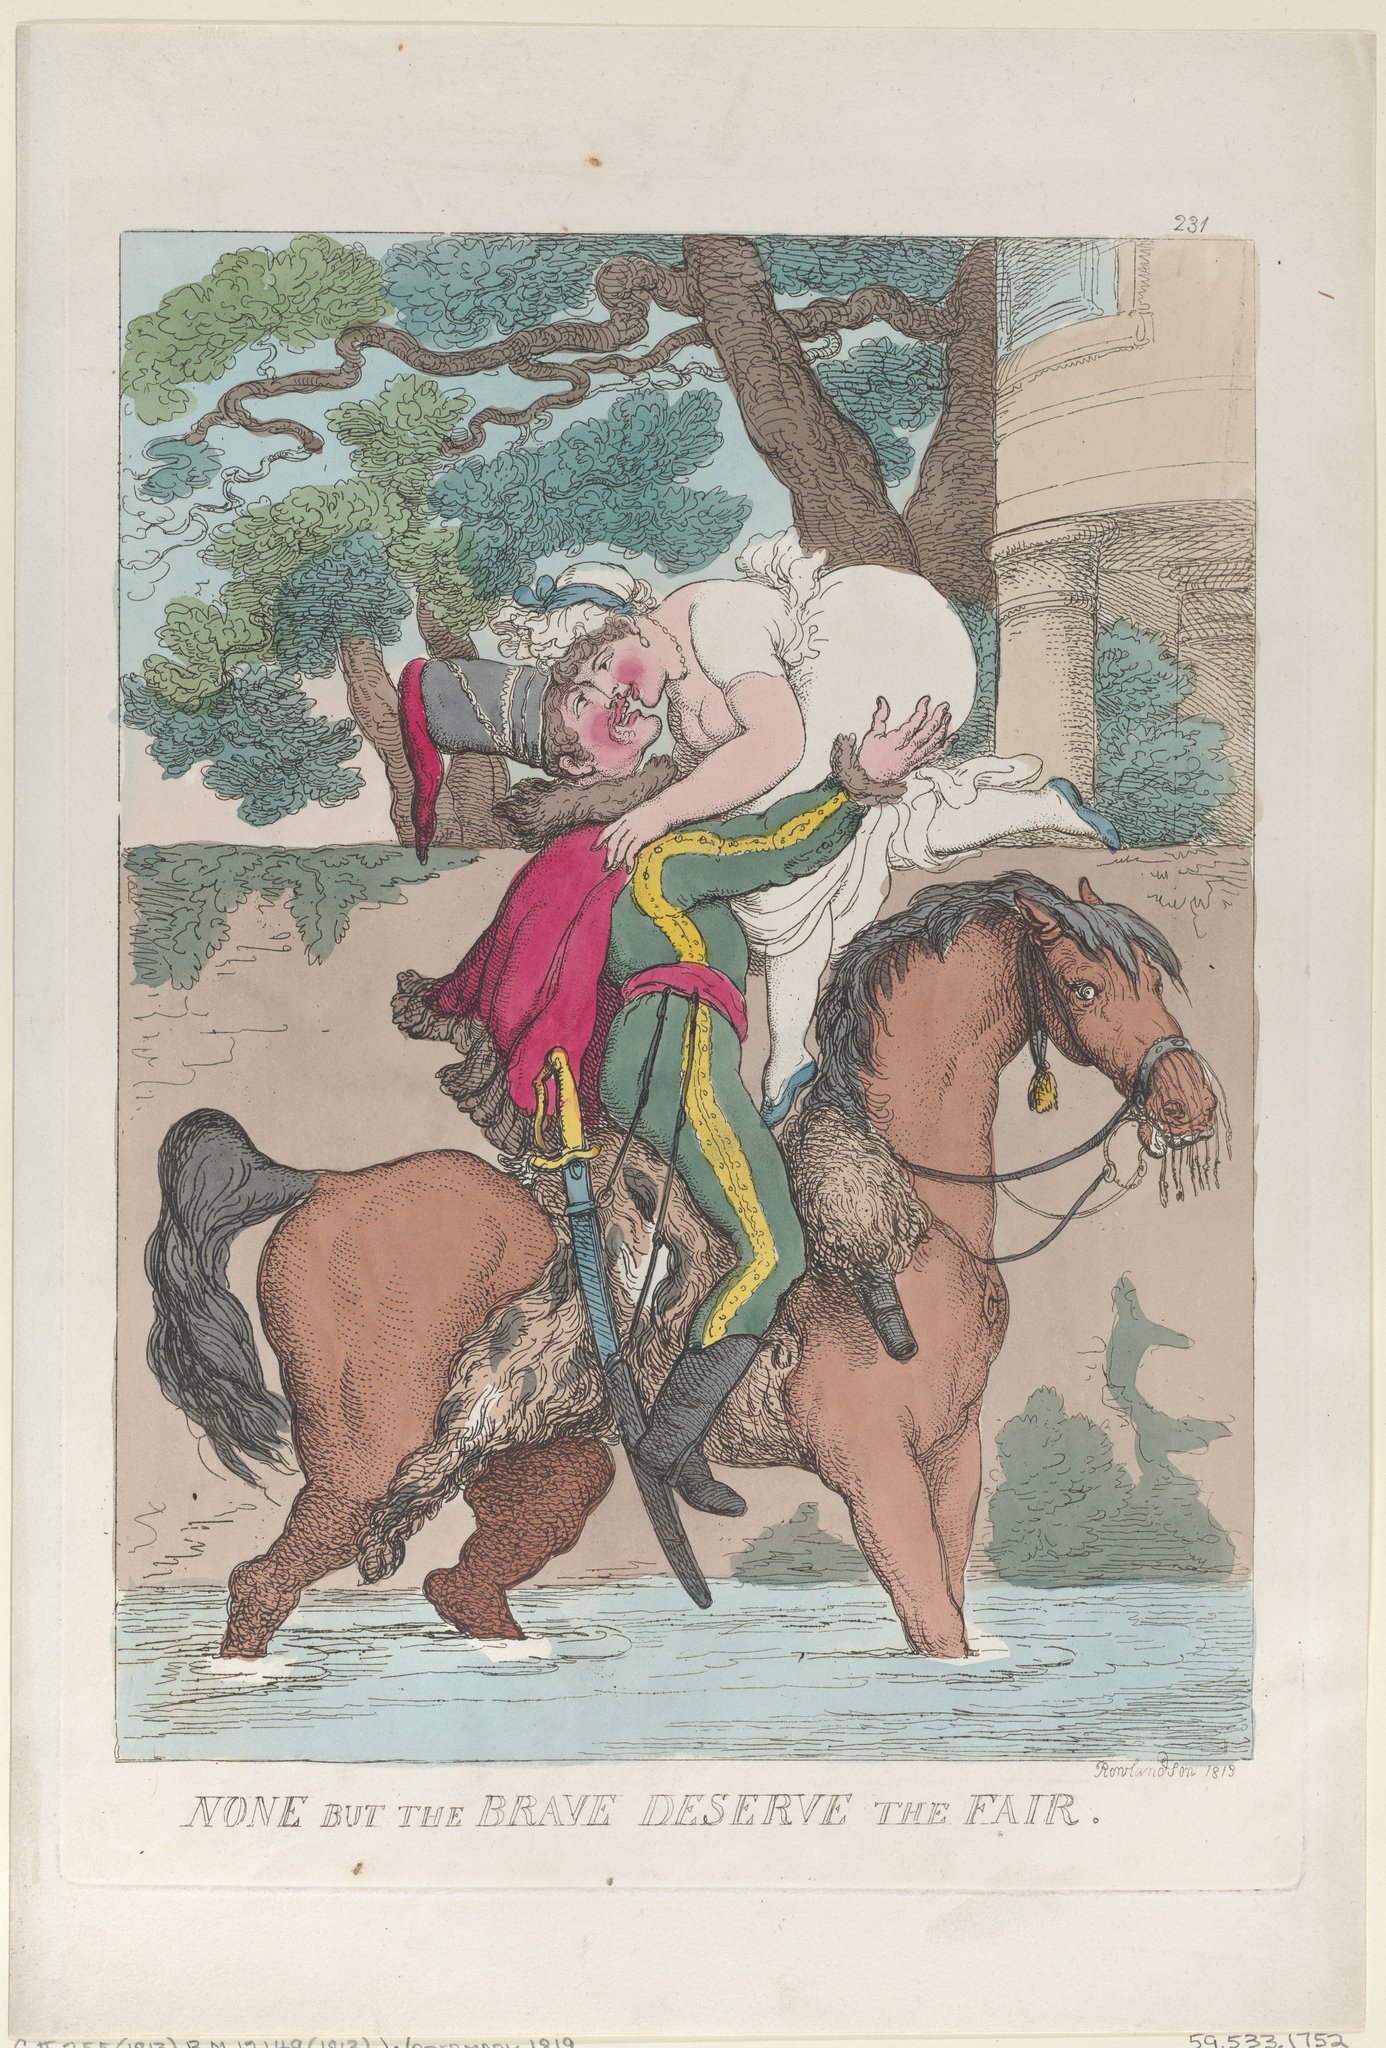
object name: print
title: None But the Brave Deserve the Fair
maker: thomas rowlandson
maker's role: artist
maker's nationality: british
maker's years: 1757-1827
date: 1813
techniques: etching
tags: couples,men,women,horses